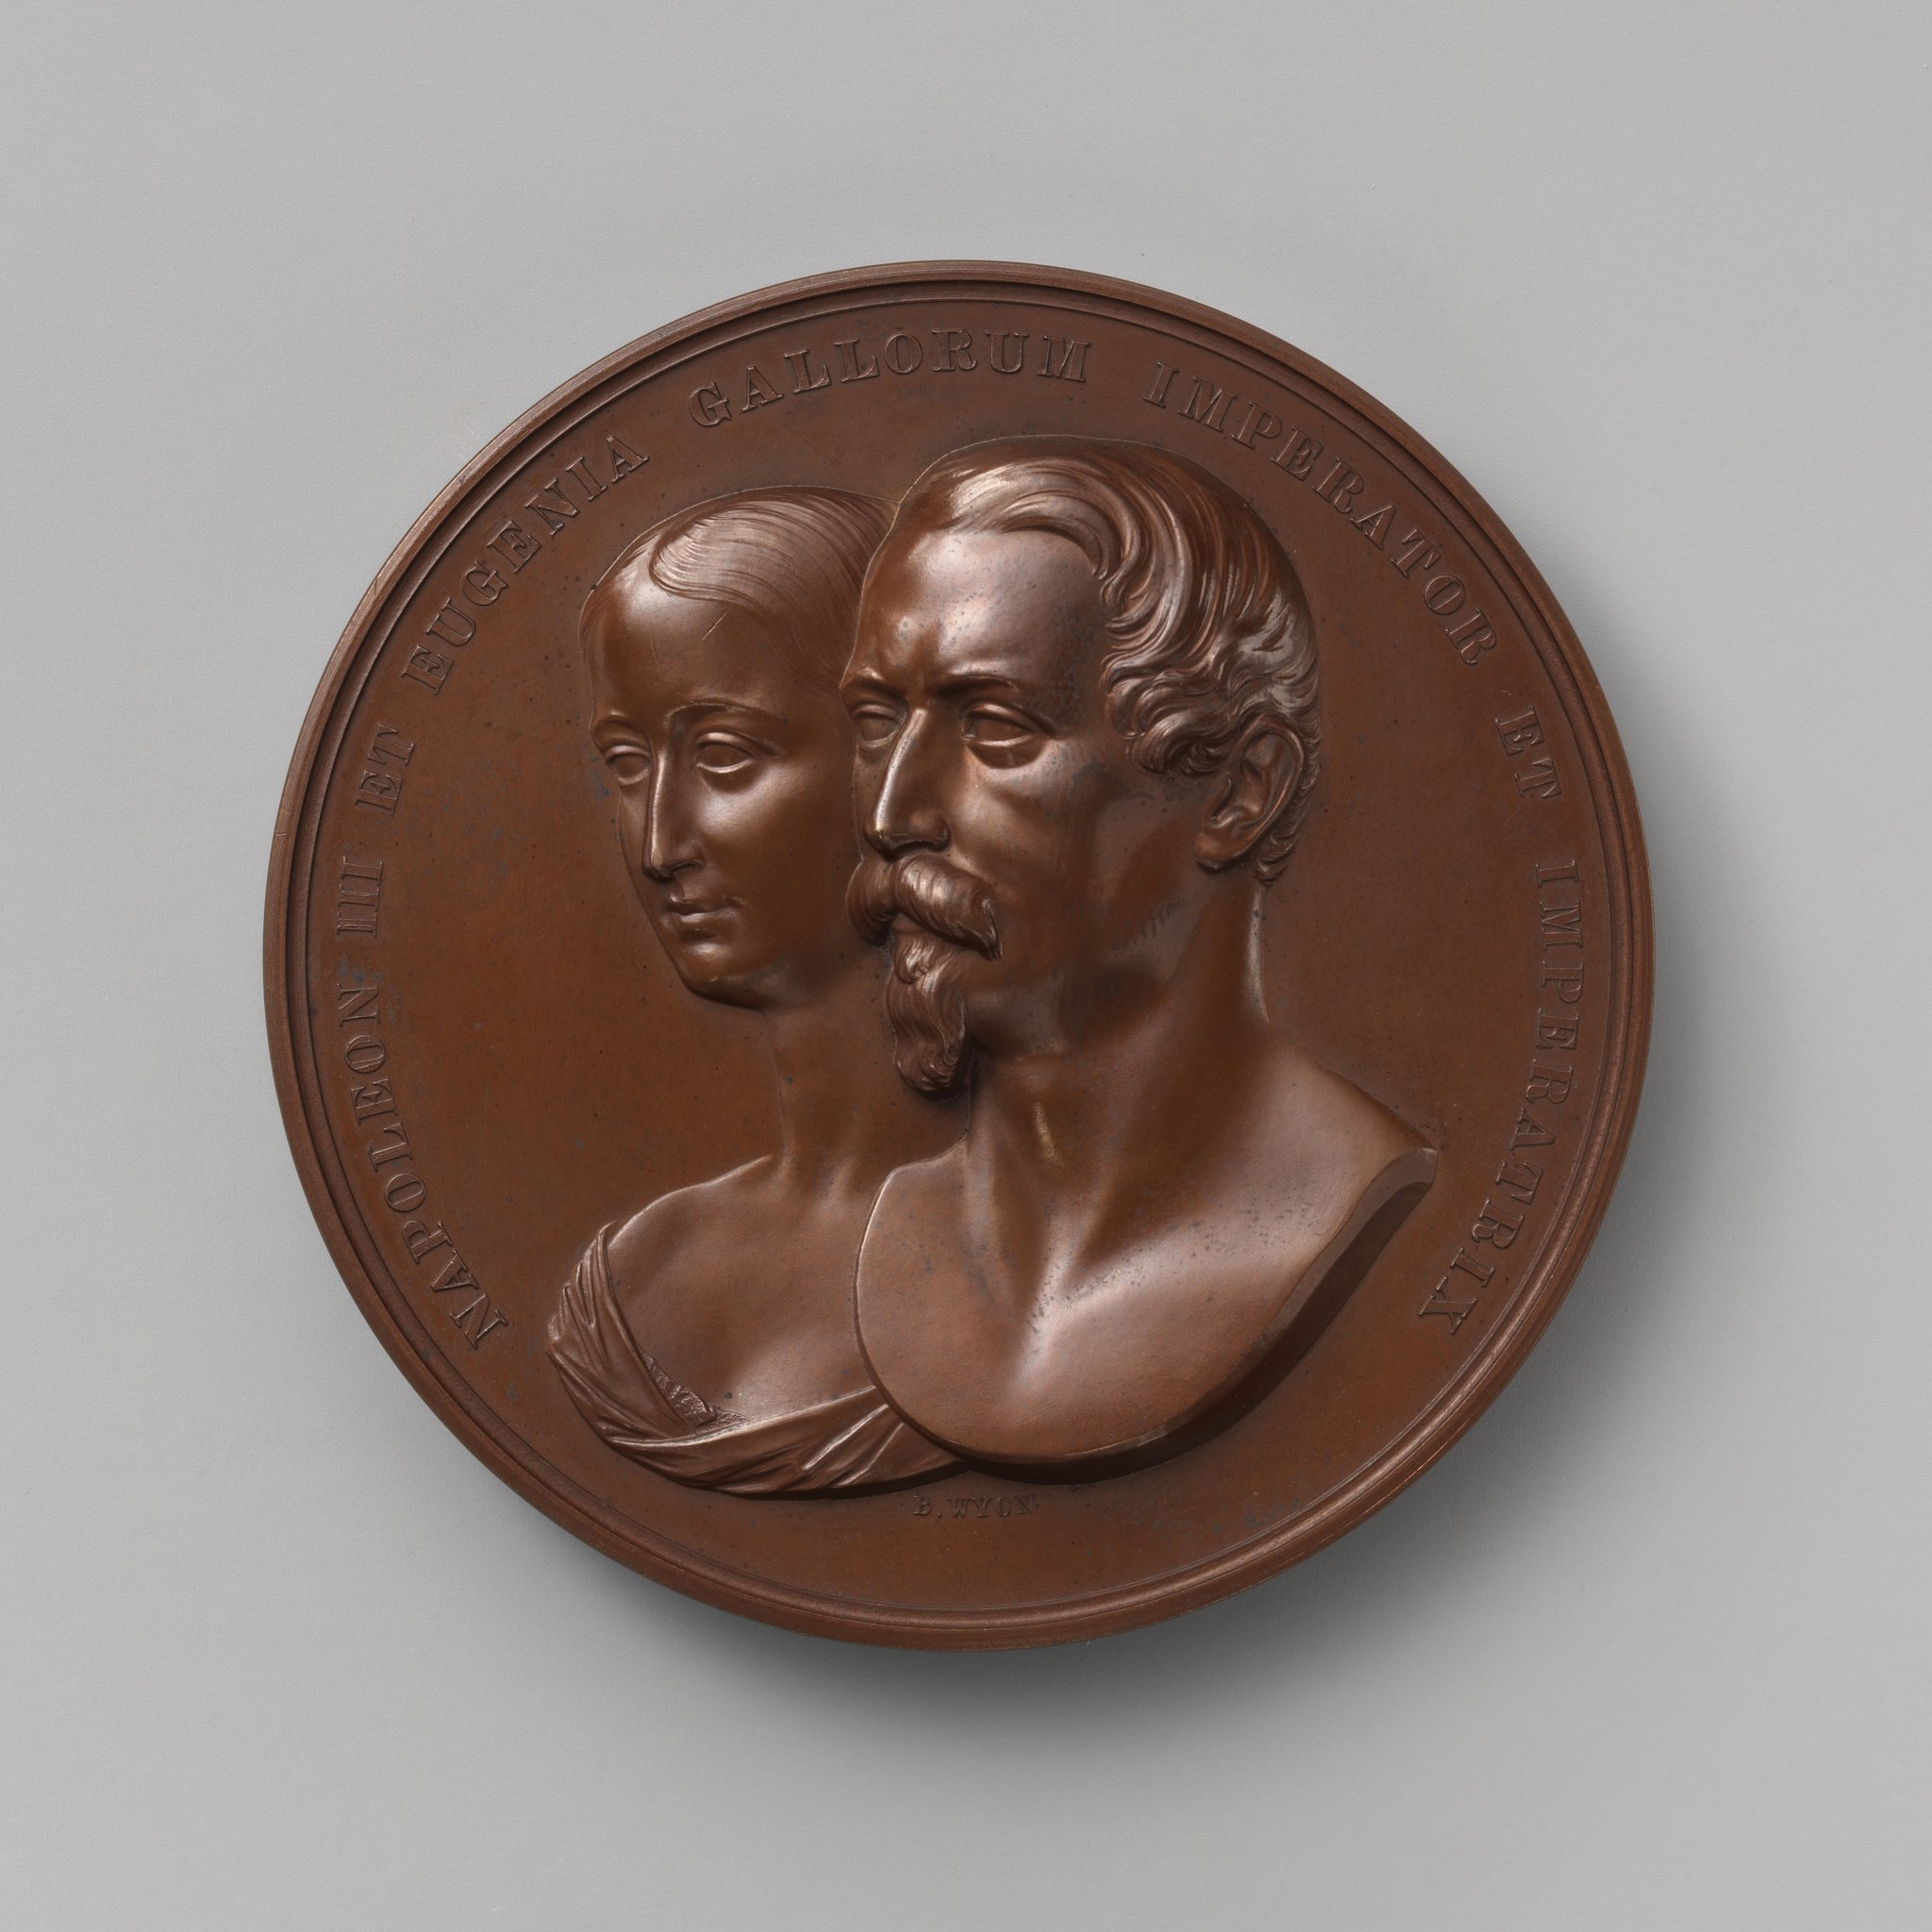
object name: medal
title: In Memory of the Visit of the Emperor and Empress of the French to the City of London, April 19, 1855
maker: benjamin wyon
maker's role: artist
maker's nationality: british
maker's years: 1802-1858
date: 1855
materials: bronze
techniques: struck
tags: men,portraits,women